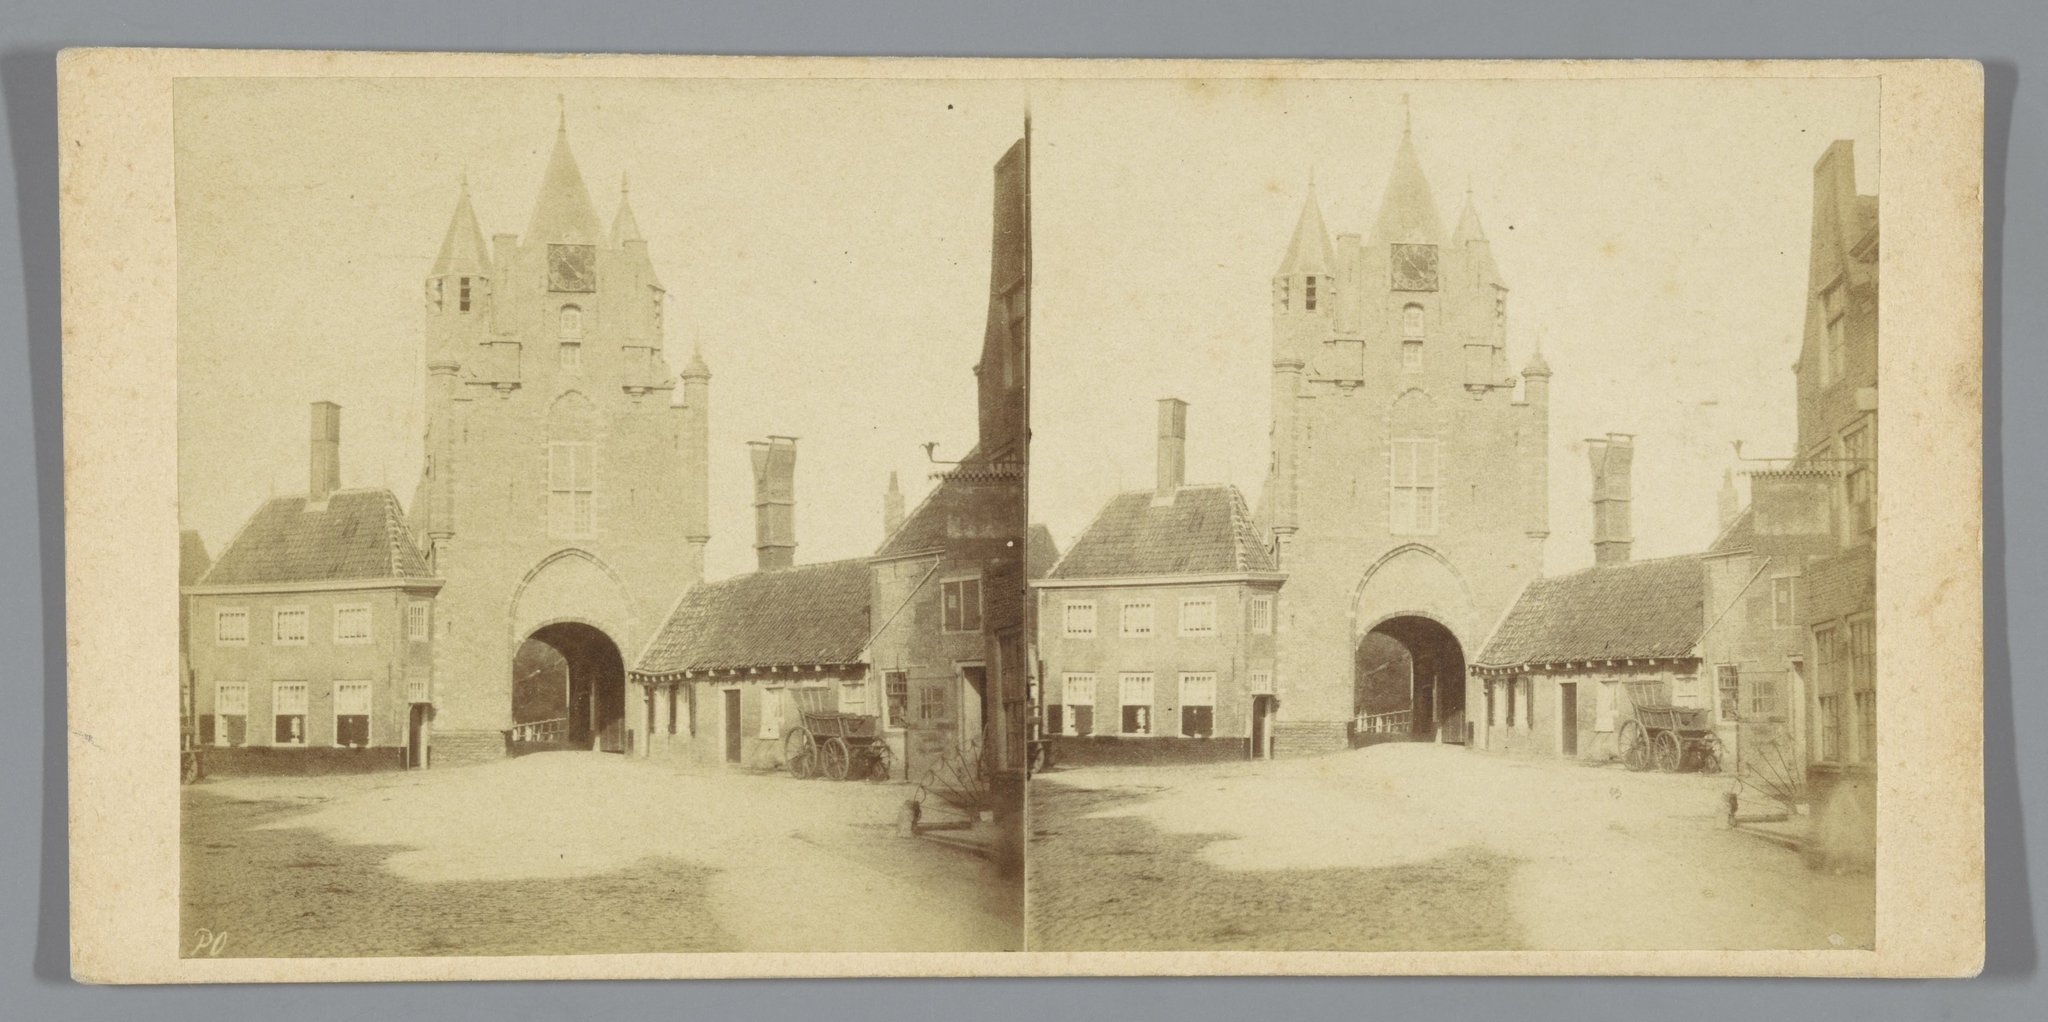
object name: stereograph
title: Stereoscopische Gezigten in Nederland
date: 1855-1865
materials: cardboard, paper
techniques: albumen print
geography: haarlem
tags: city-gate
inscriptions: inscription: ‘Zwolle’, initials: ‘P.O.’, inscription: ‘Verkrijgbaar bij A. Jager, Water 110, te Amsterdam.’